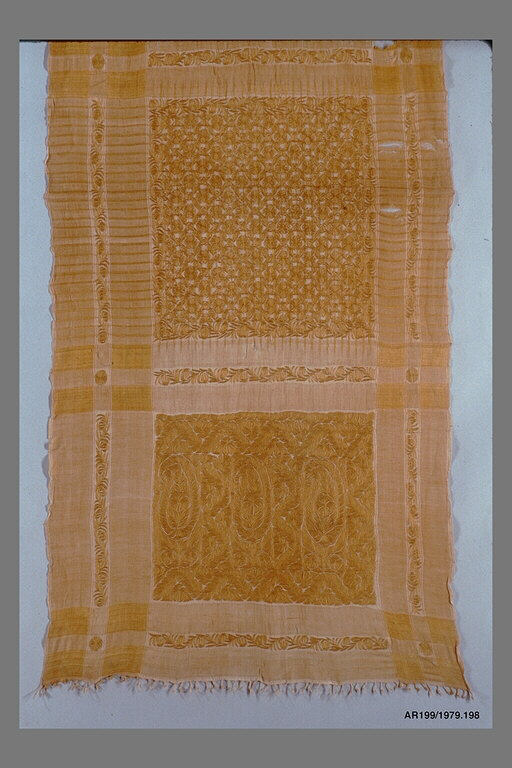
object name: shawl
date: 1801-1900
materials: cotton, silk